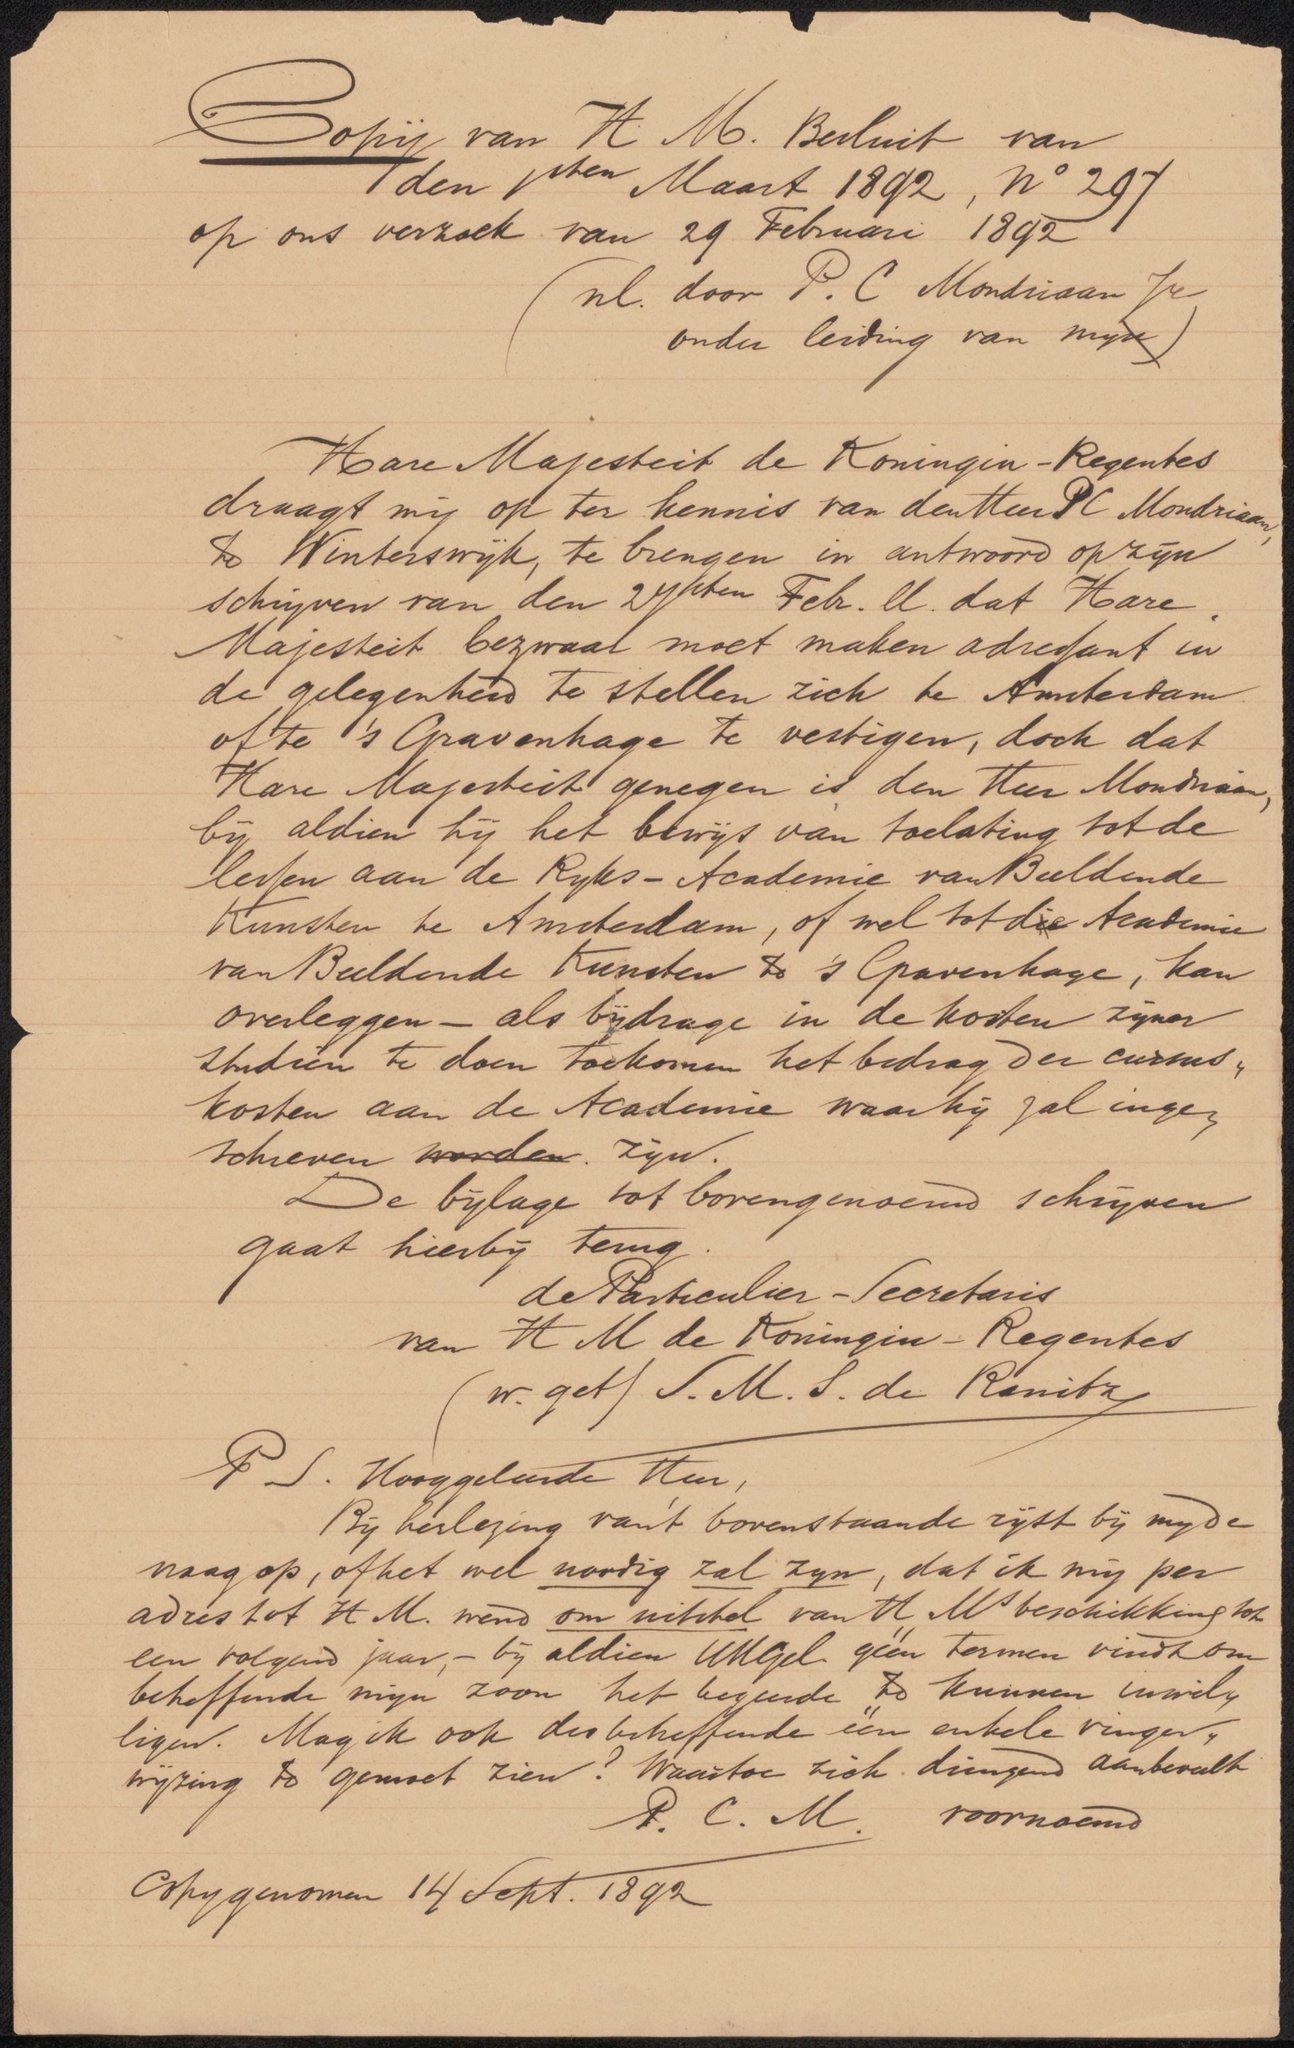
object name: tekst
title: Kopie van een Besluit van Emma (koningin-regentes der Nederlanden)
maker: august allebé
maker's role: draughtsman, print maker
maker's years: 1838-1927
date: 1892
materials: ink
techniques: pen, writing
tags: the hague, emma (queen consort of the netherlands), new york (city), print maker, piet mondriaan, education, tuition of the artist (in general), money